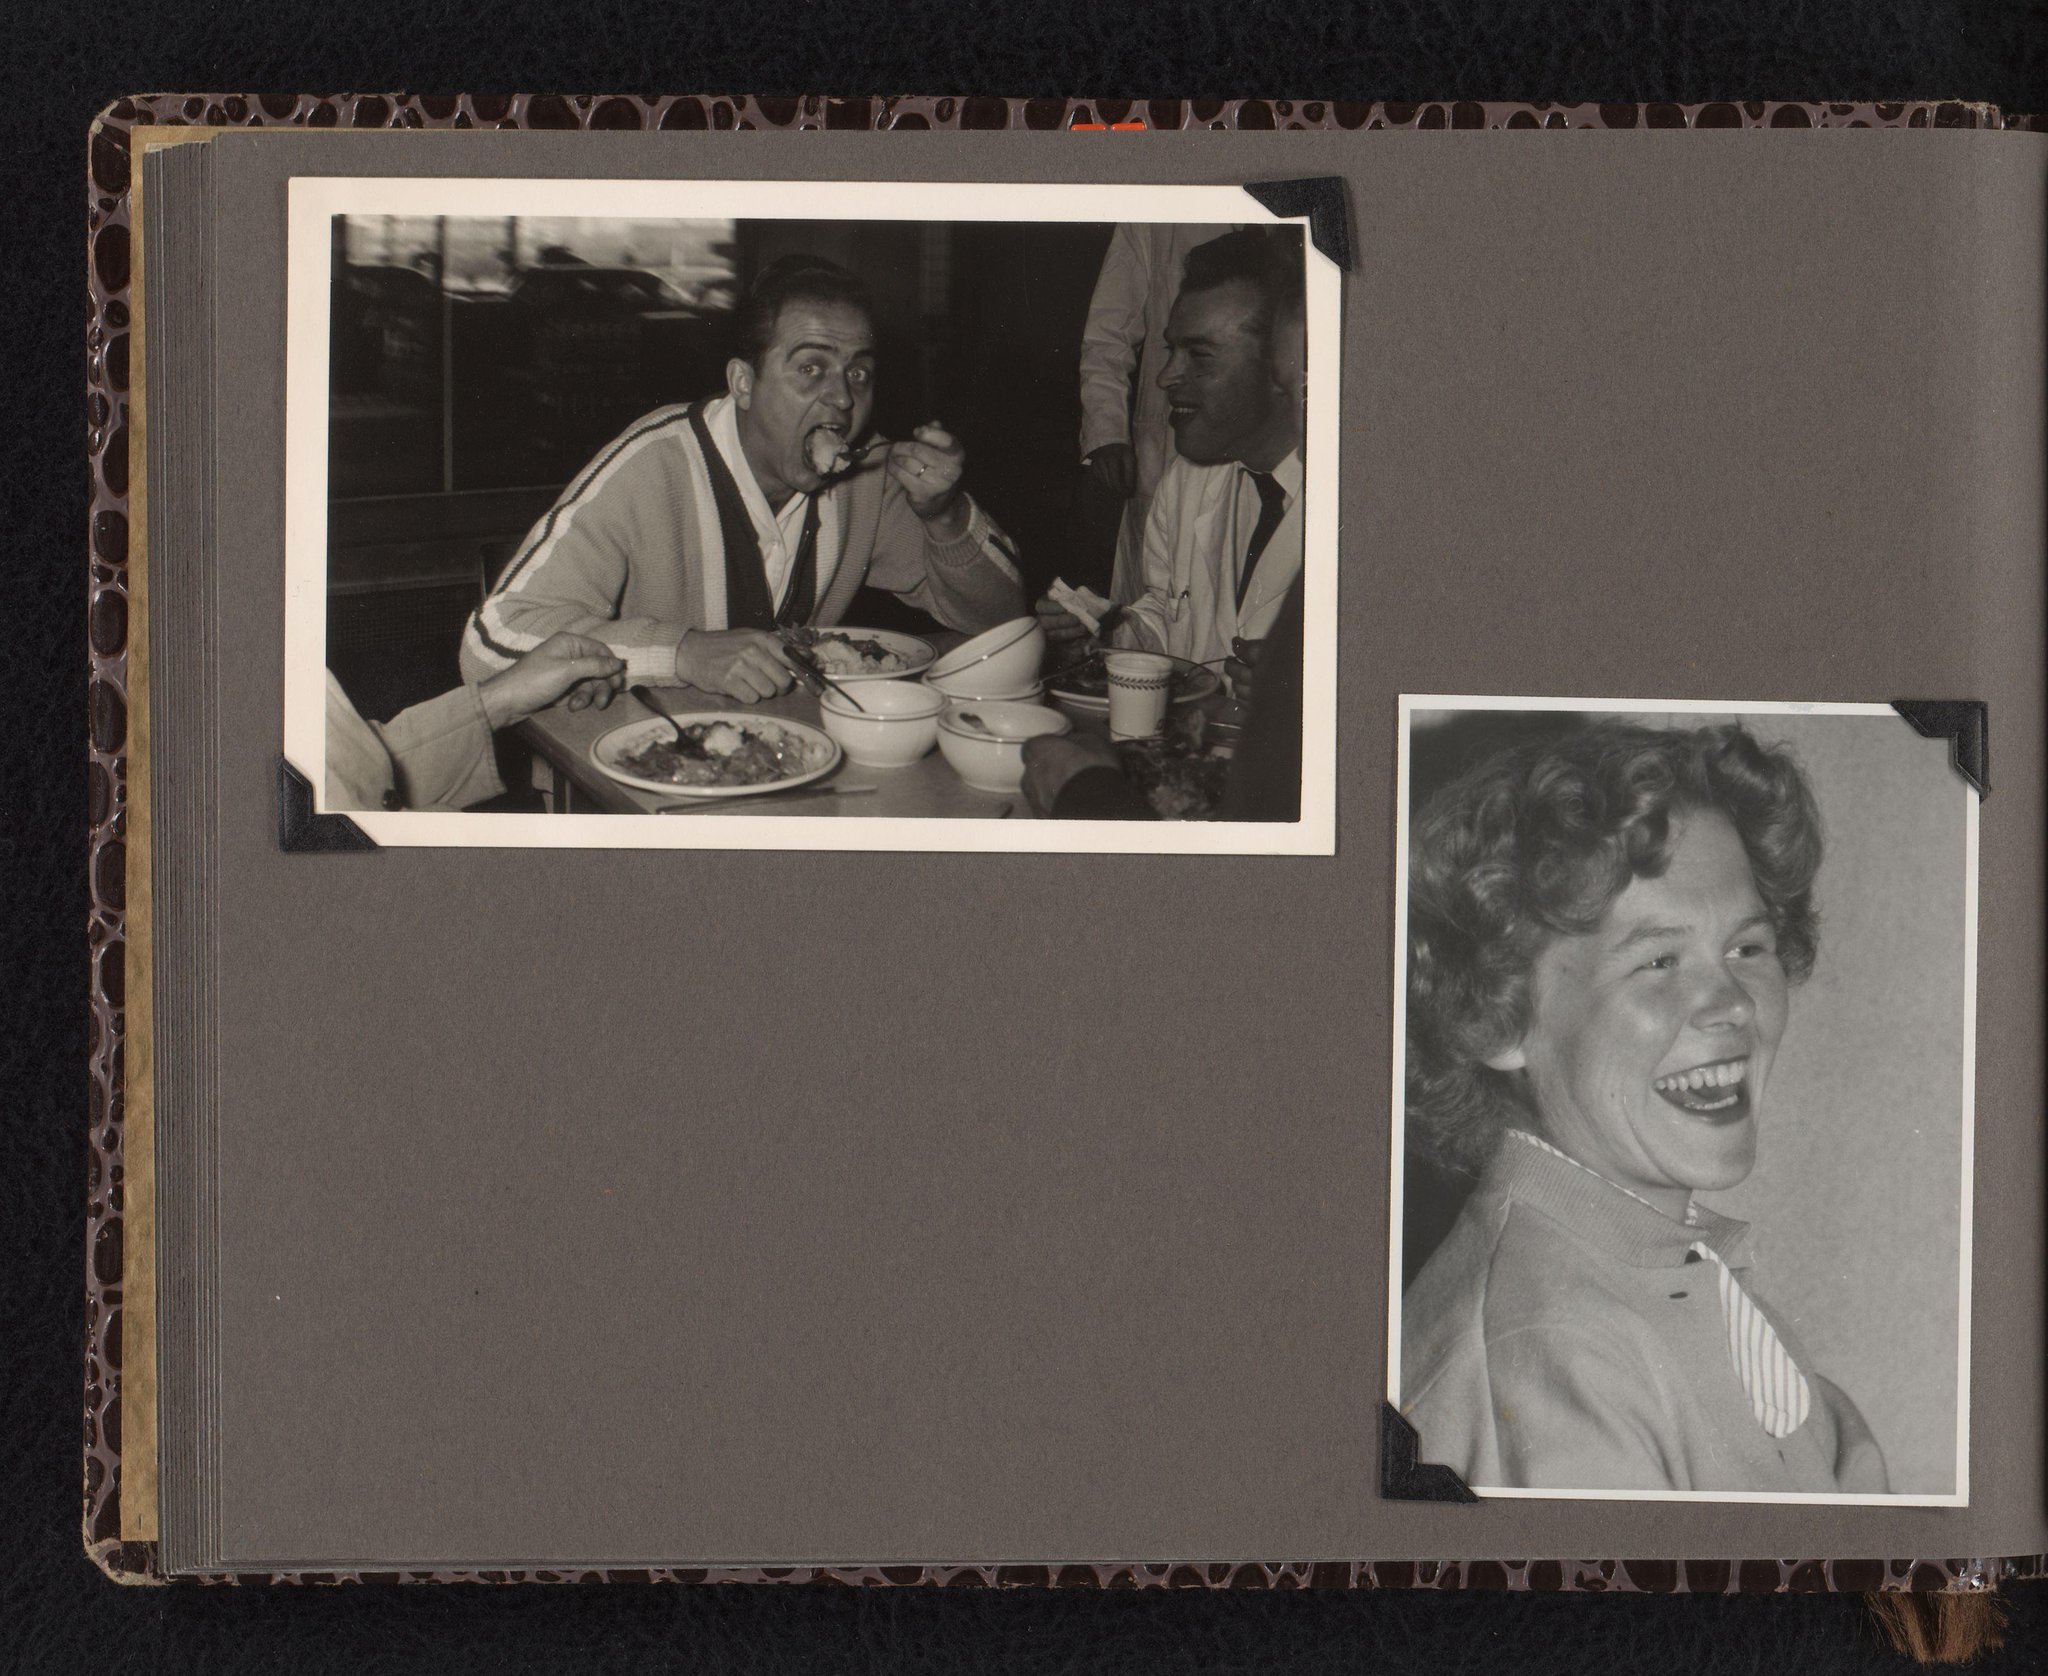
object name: album leaf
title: Portretten van onbekende man en vrouw, waarschijnlijk persoonlijke bekenden van Isabel Wachenheimer, 1956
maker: Anonymous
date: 1956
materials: cardboard, photographic support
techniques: gelatin silver print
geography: germany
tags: historical persons not known by name - bb - woman, historical persons not known by name, united states of america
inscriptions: inscription: ‘... Frankfurt / Main 1956’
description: Blad bevat twee foto's van bevriend stel in Frankfurt am Main, 1956. Uit album half formaat, kunstlederen omslag met koordbinding.